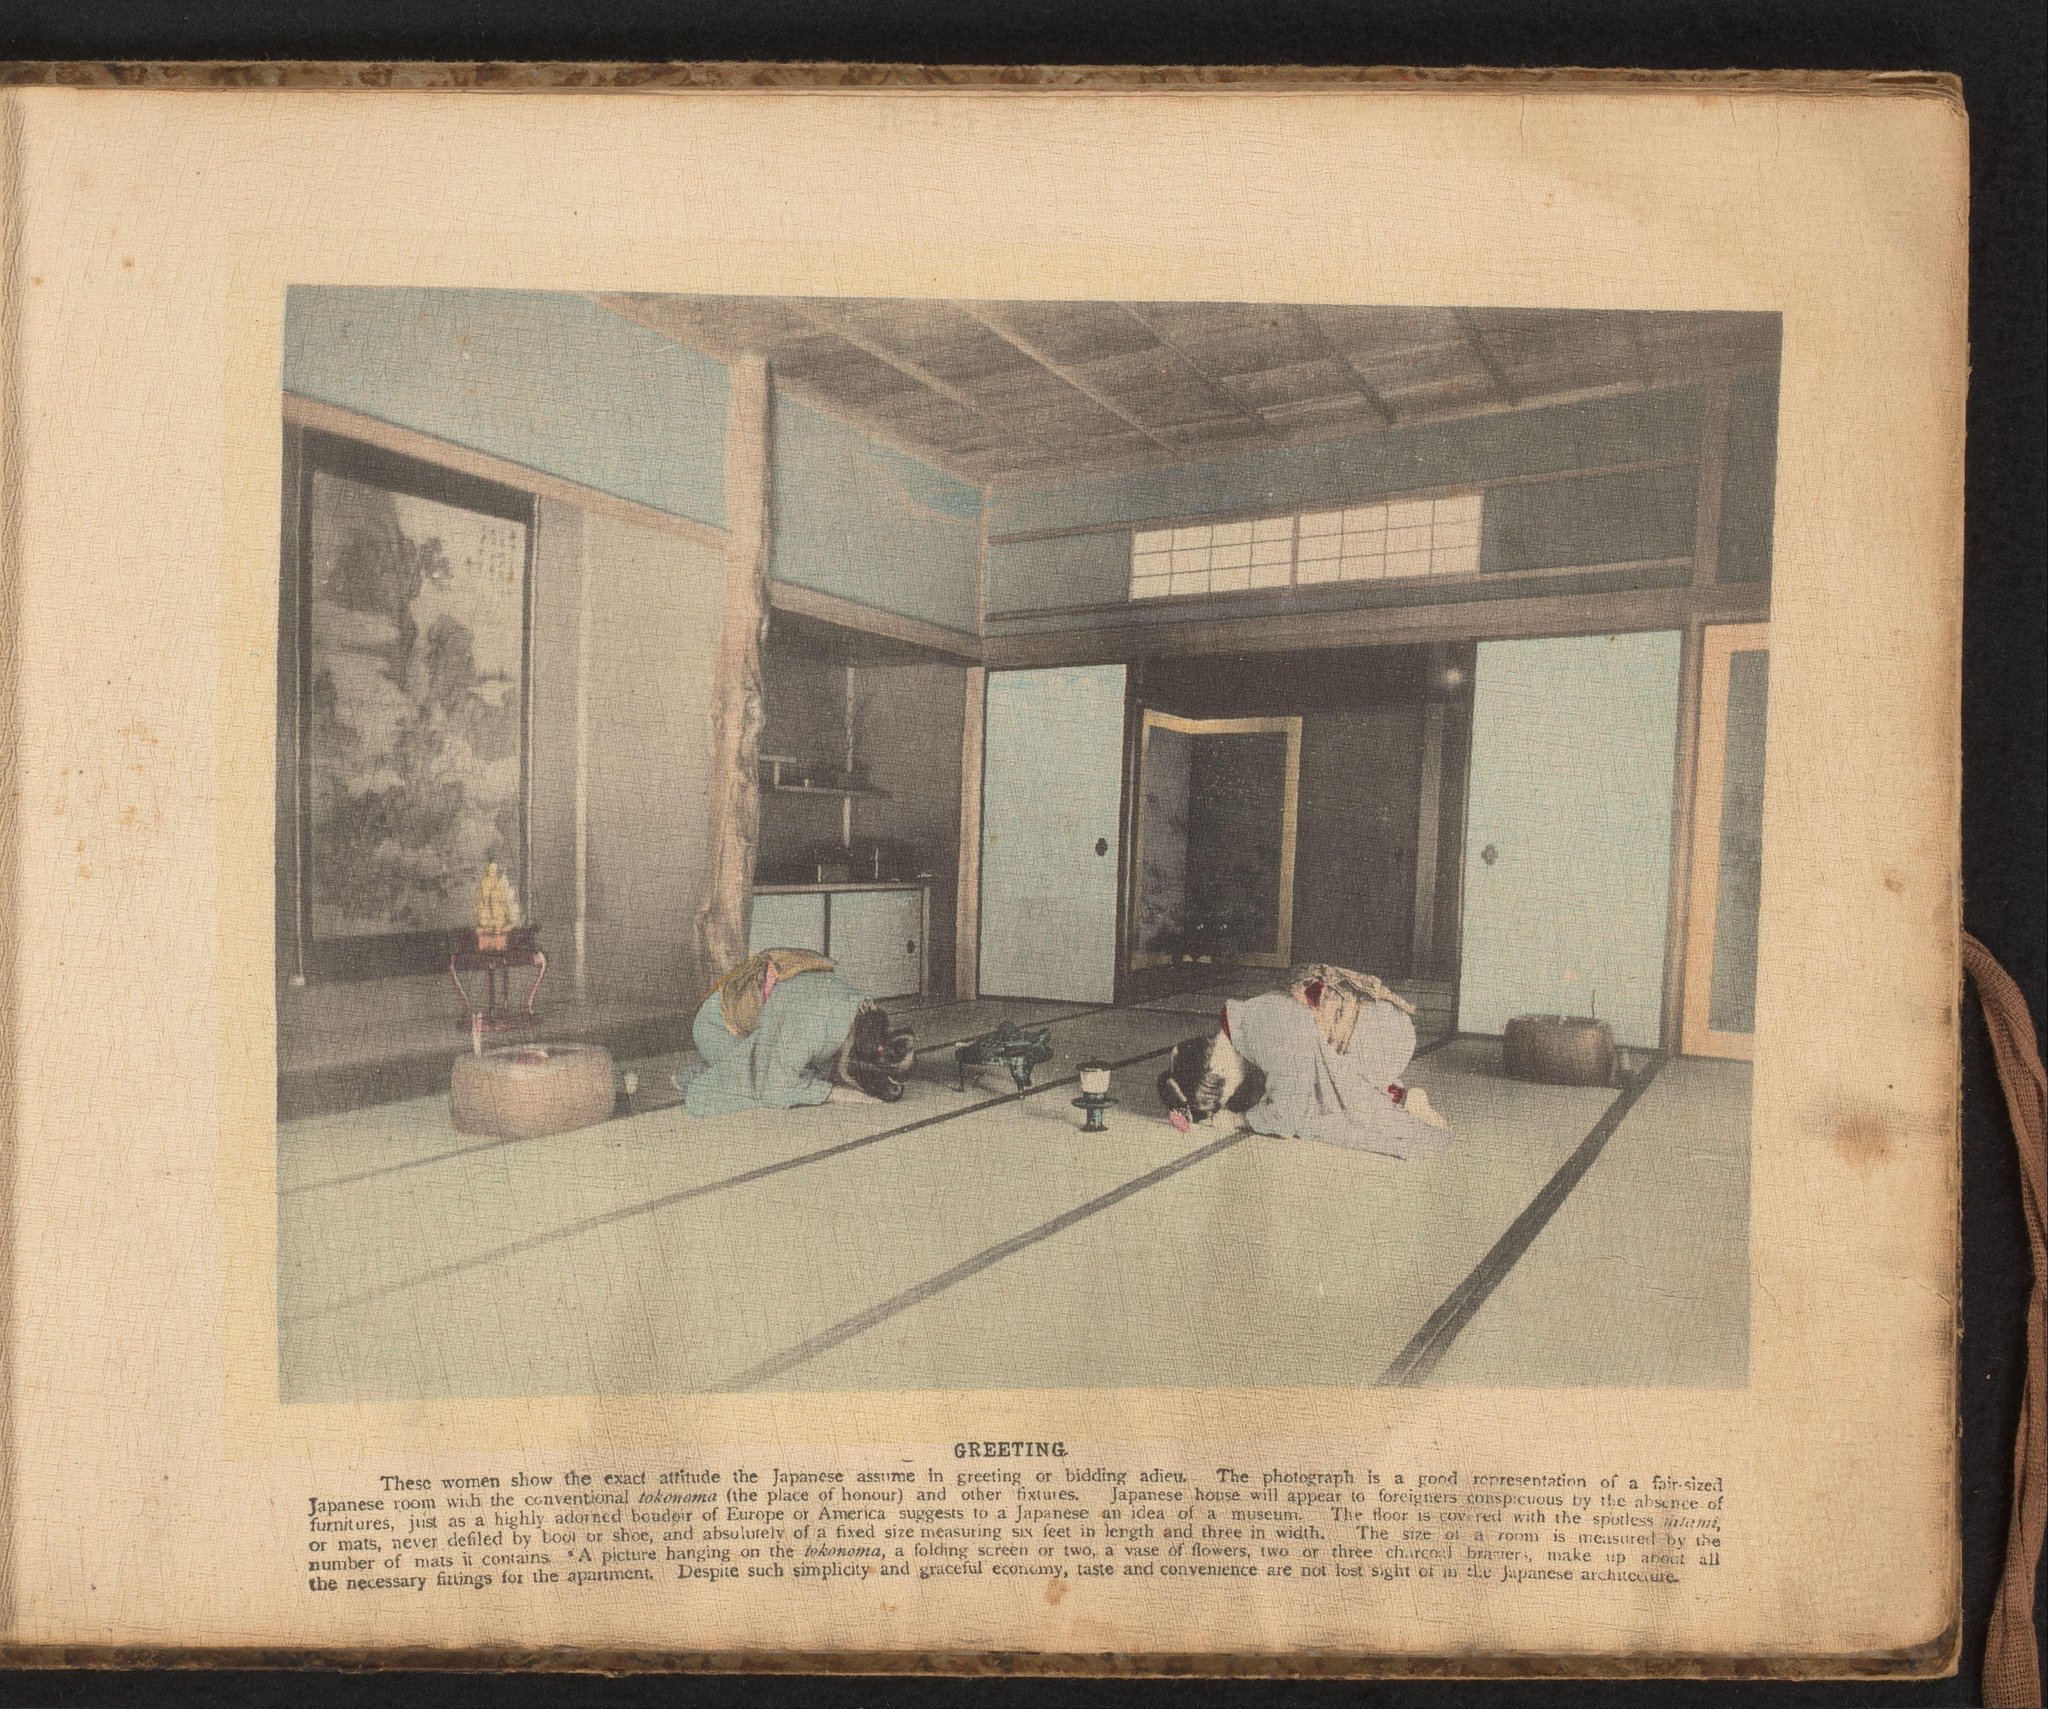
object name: photomechanical print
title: Greeting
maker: Anonymous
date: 1891-1896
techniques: collotype process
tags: adult man, interior of the house, japan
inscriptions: inscription: ‘These women show the exact attitude teh Japanese assume in greeting or bdding adieu. (...)’